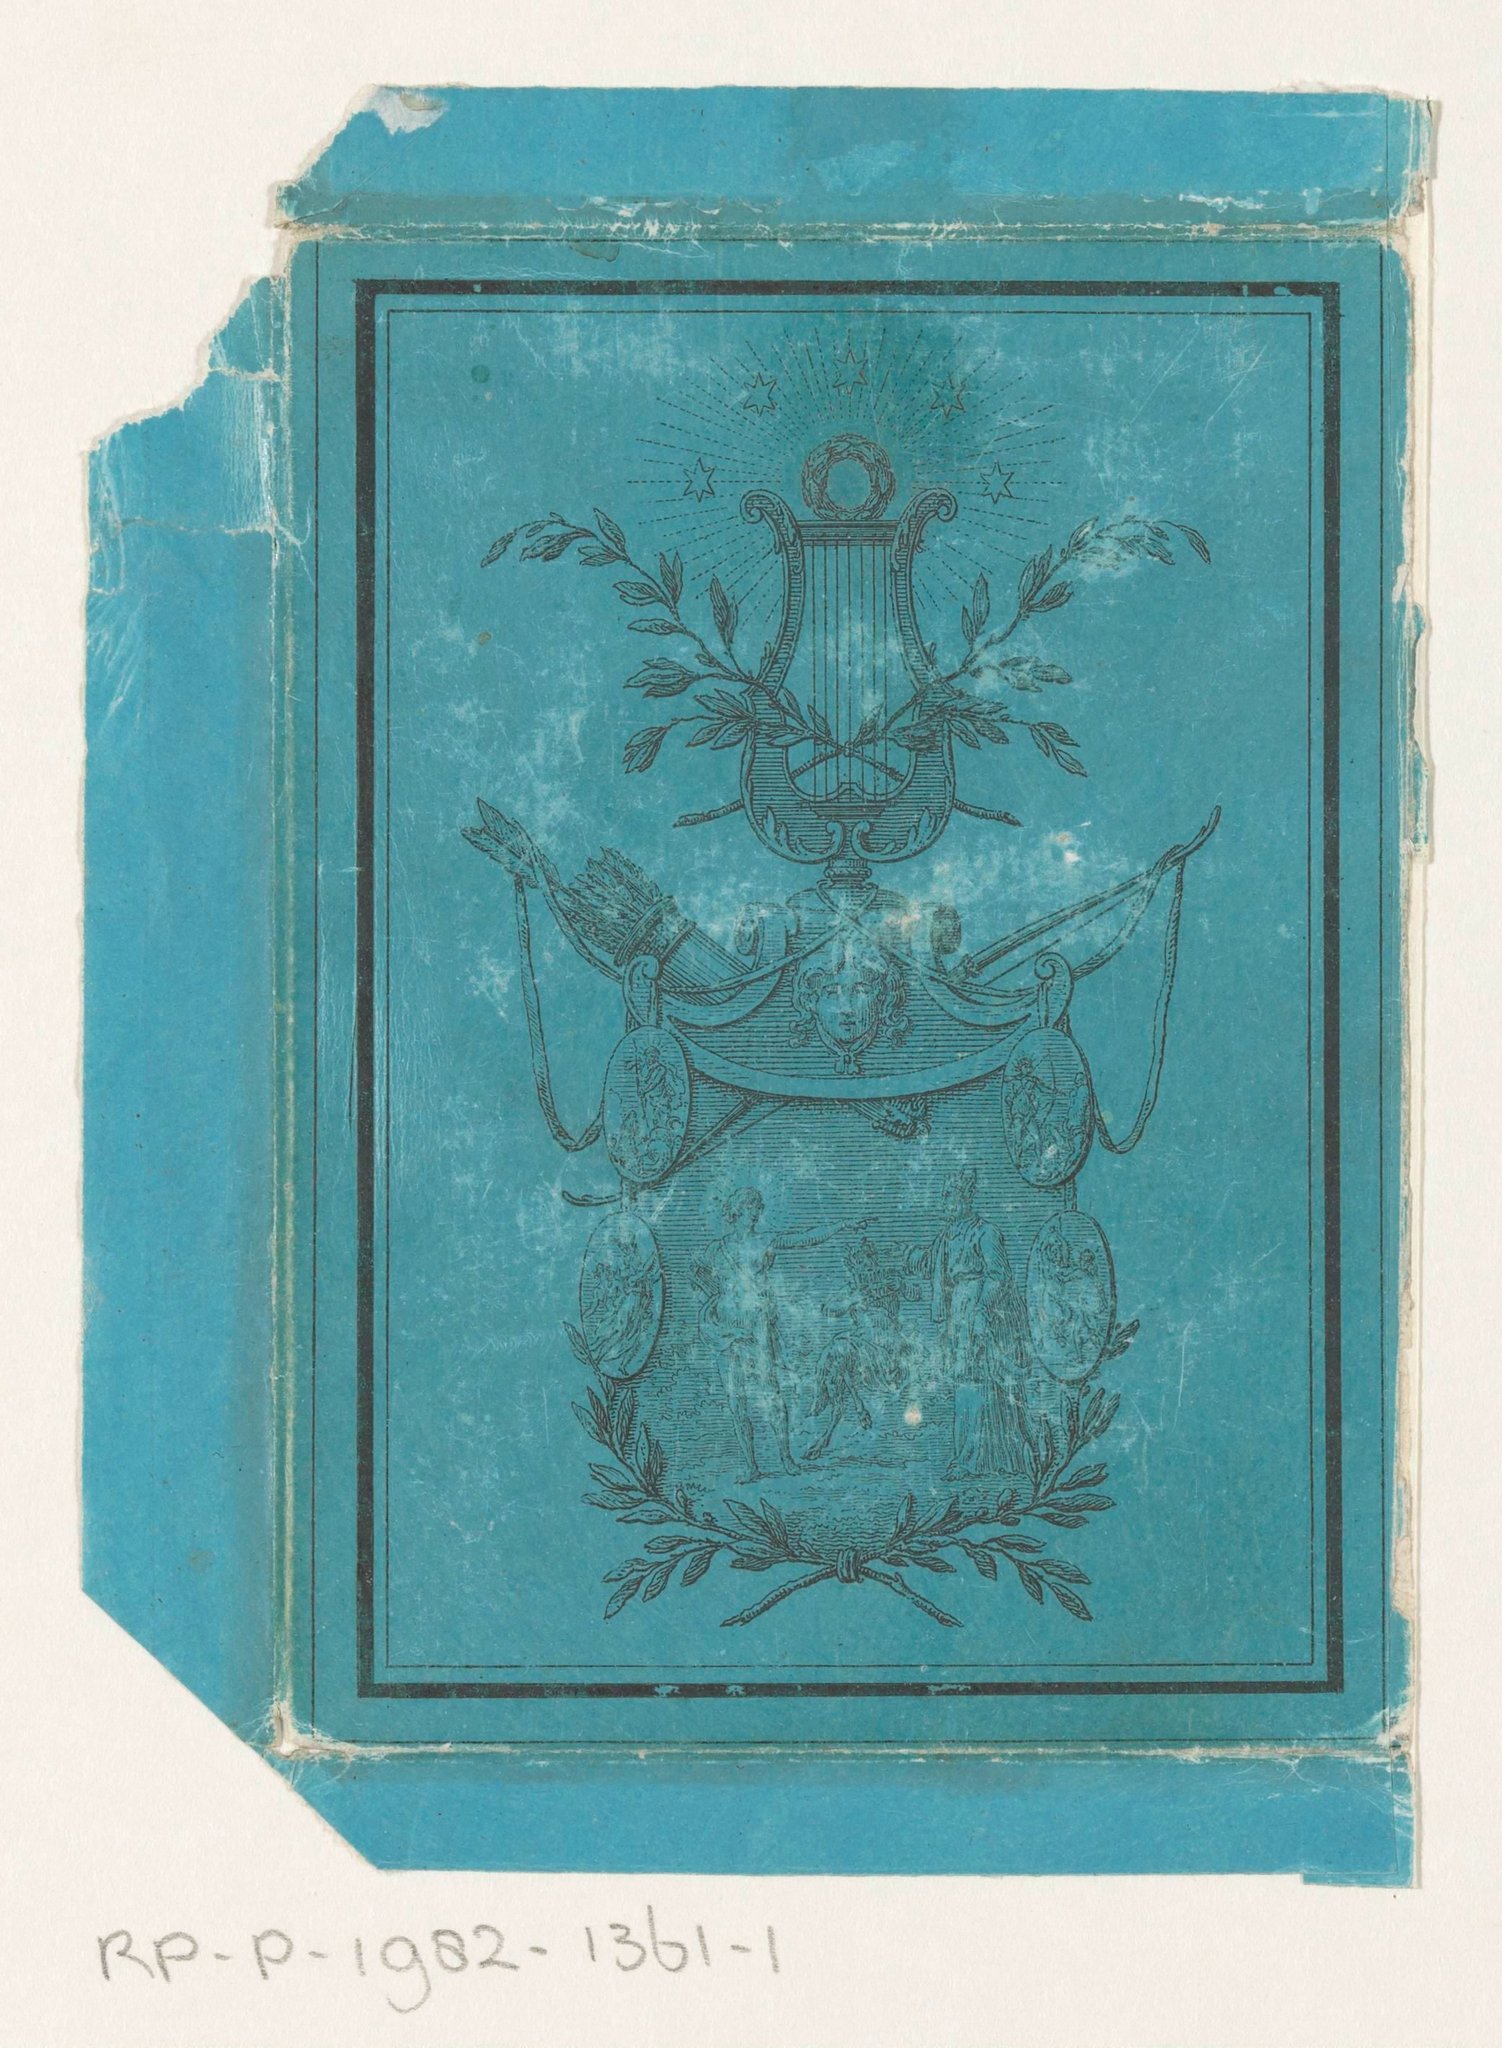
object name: print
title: Vignet met lier en koning Midas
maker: Anonymous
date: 1821-1860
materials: paper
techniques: etching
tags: lyre, cithara, psaltery, vignette, contest between apollo and pan with the mountain god tmolus as judge, i.e. judgement of midas; midas often represented with ass's ears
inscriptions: collector's mark: Lugt 2760, collector's mark: Lugt 2228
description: Vignet met een lier bovenop een voorstelling van Mercurius, Pan en koning Midas met ezelsoren. In rechthoekige omlijsting.